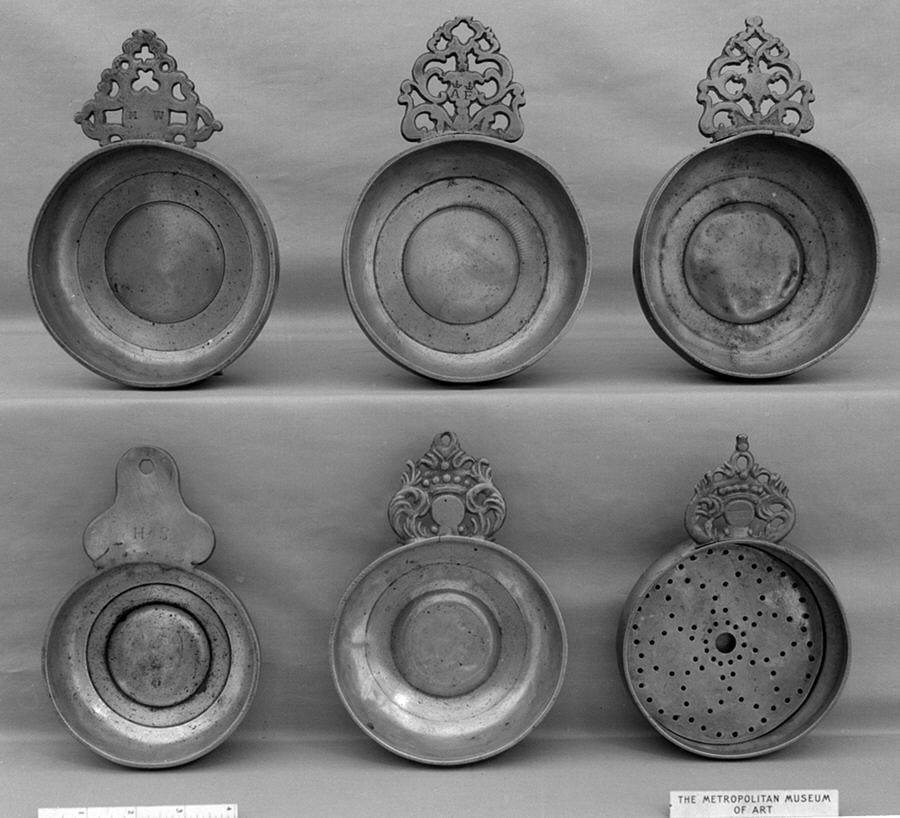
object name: porringer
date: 1701-1800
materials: pewter